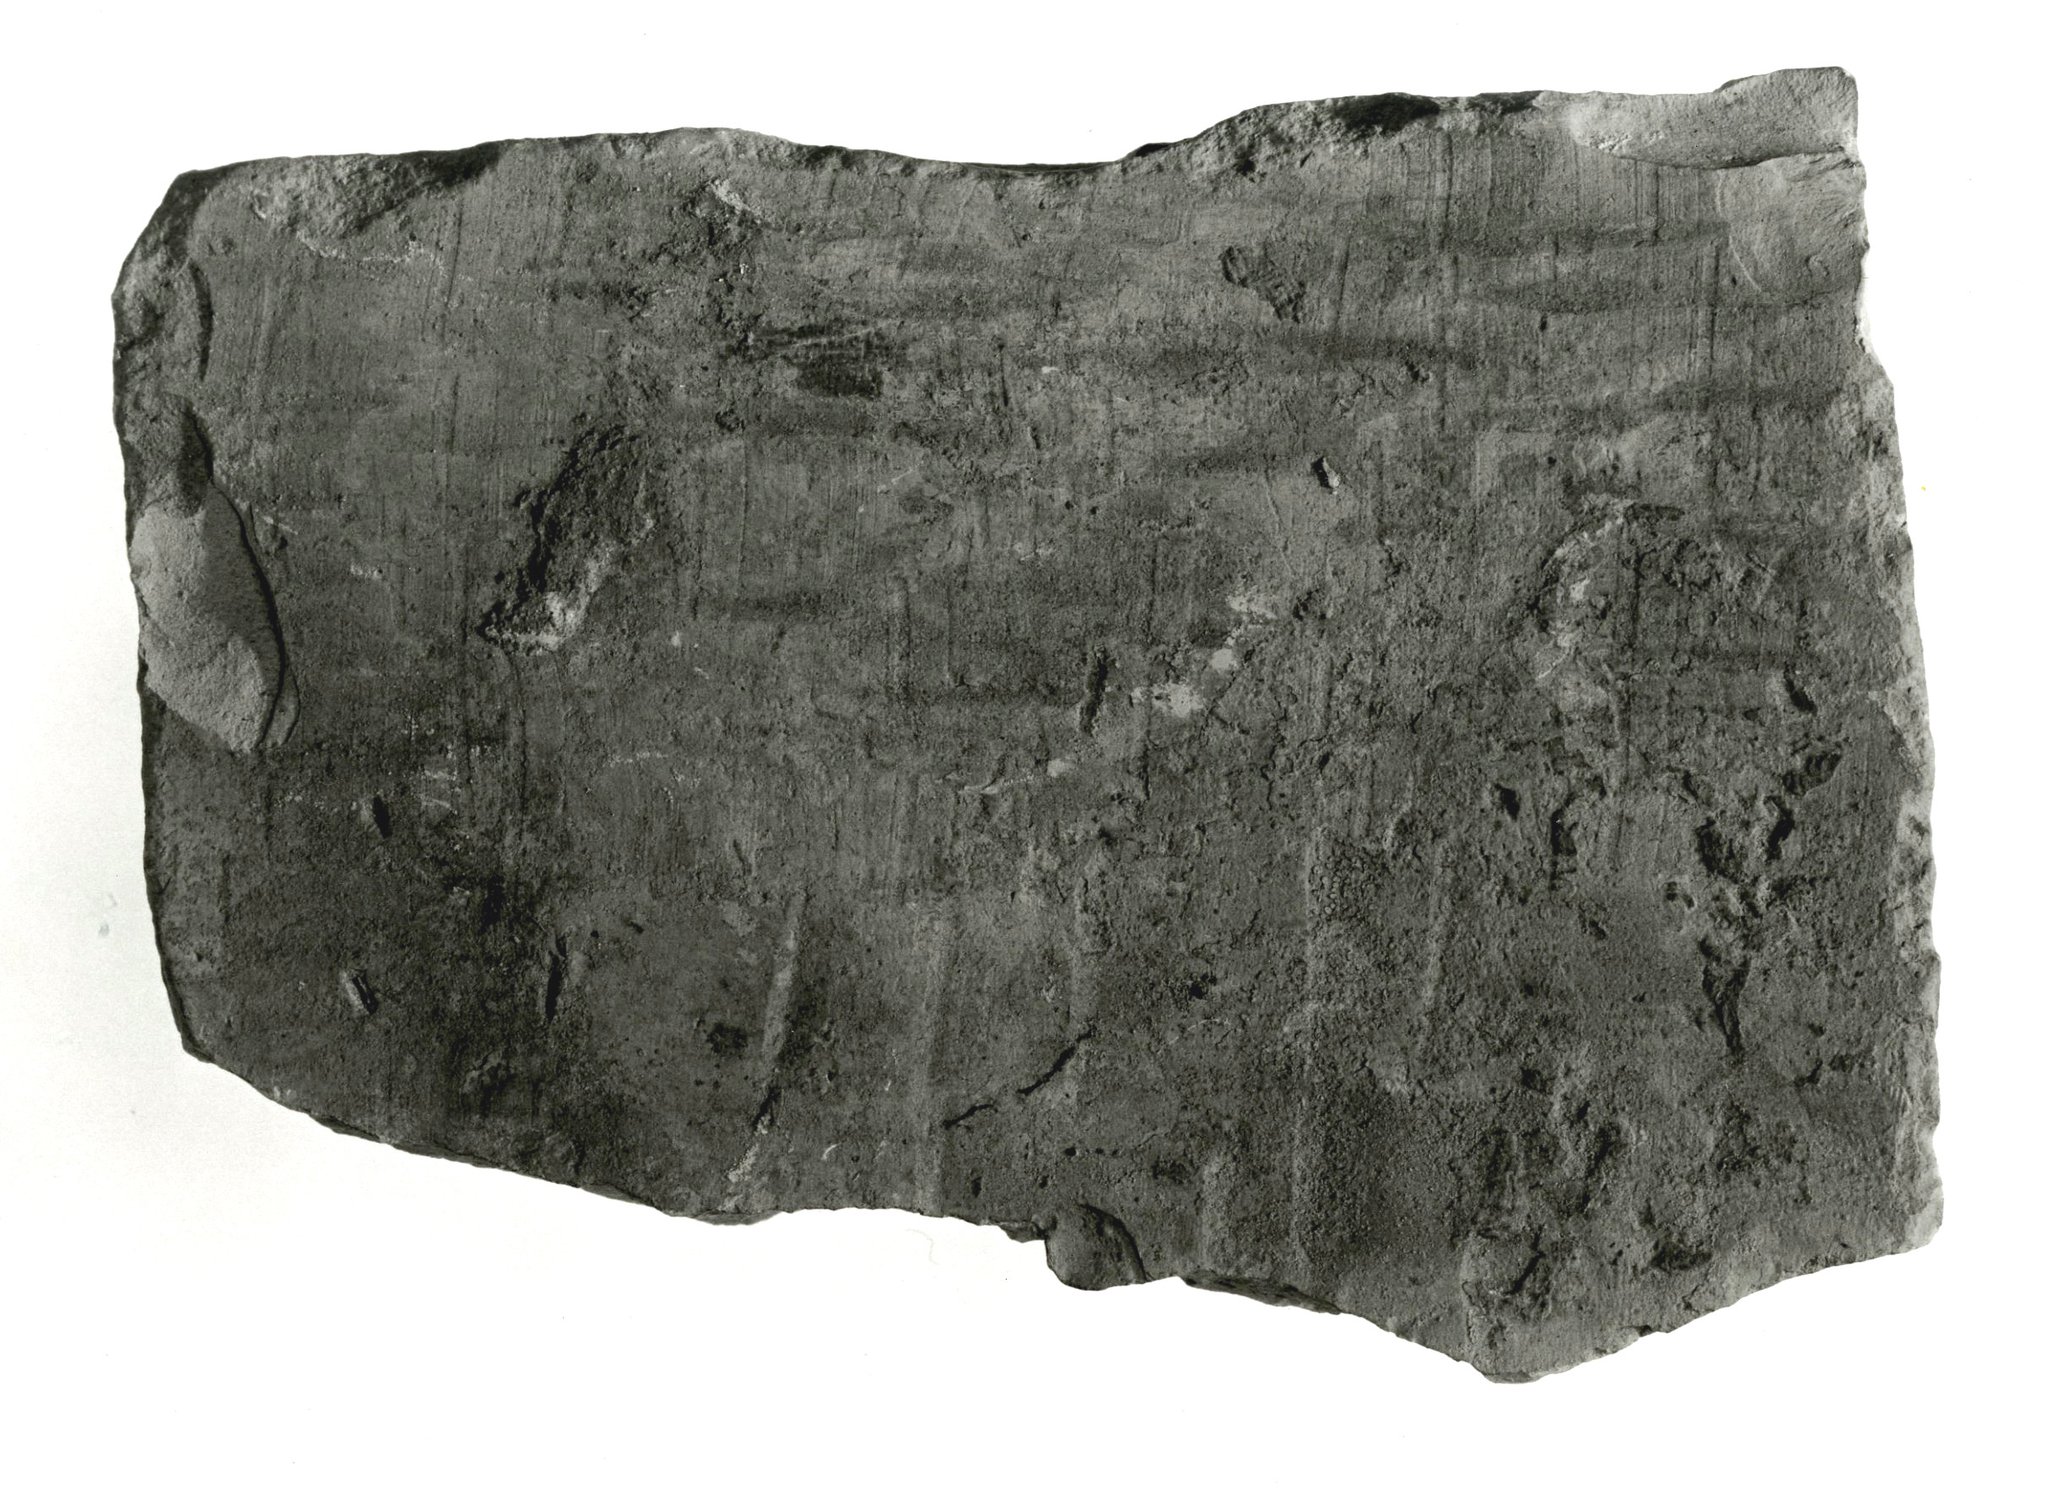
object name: relief, tomb of nespekashuty, wall casing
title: Wall casing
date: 664-610 BCE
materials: limestone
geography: egypt